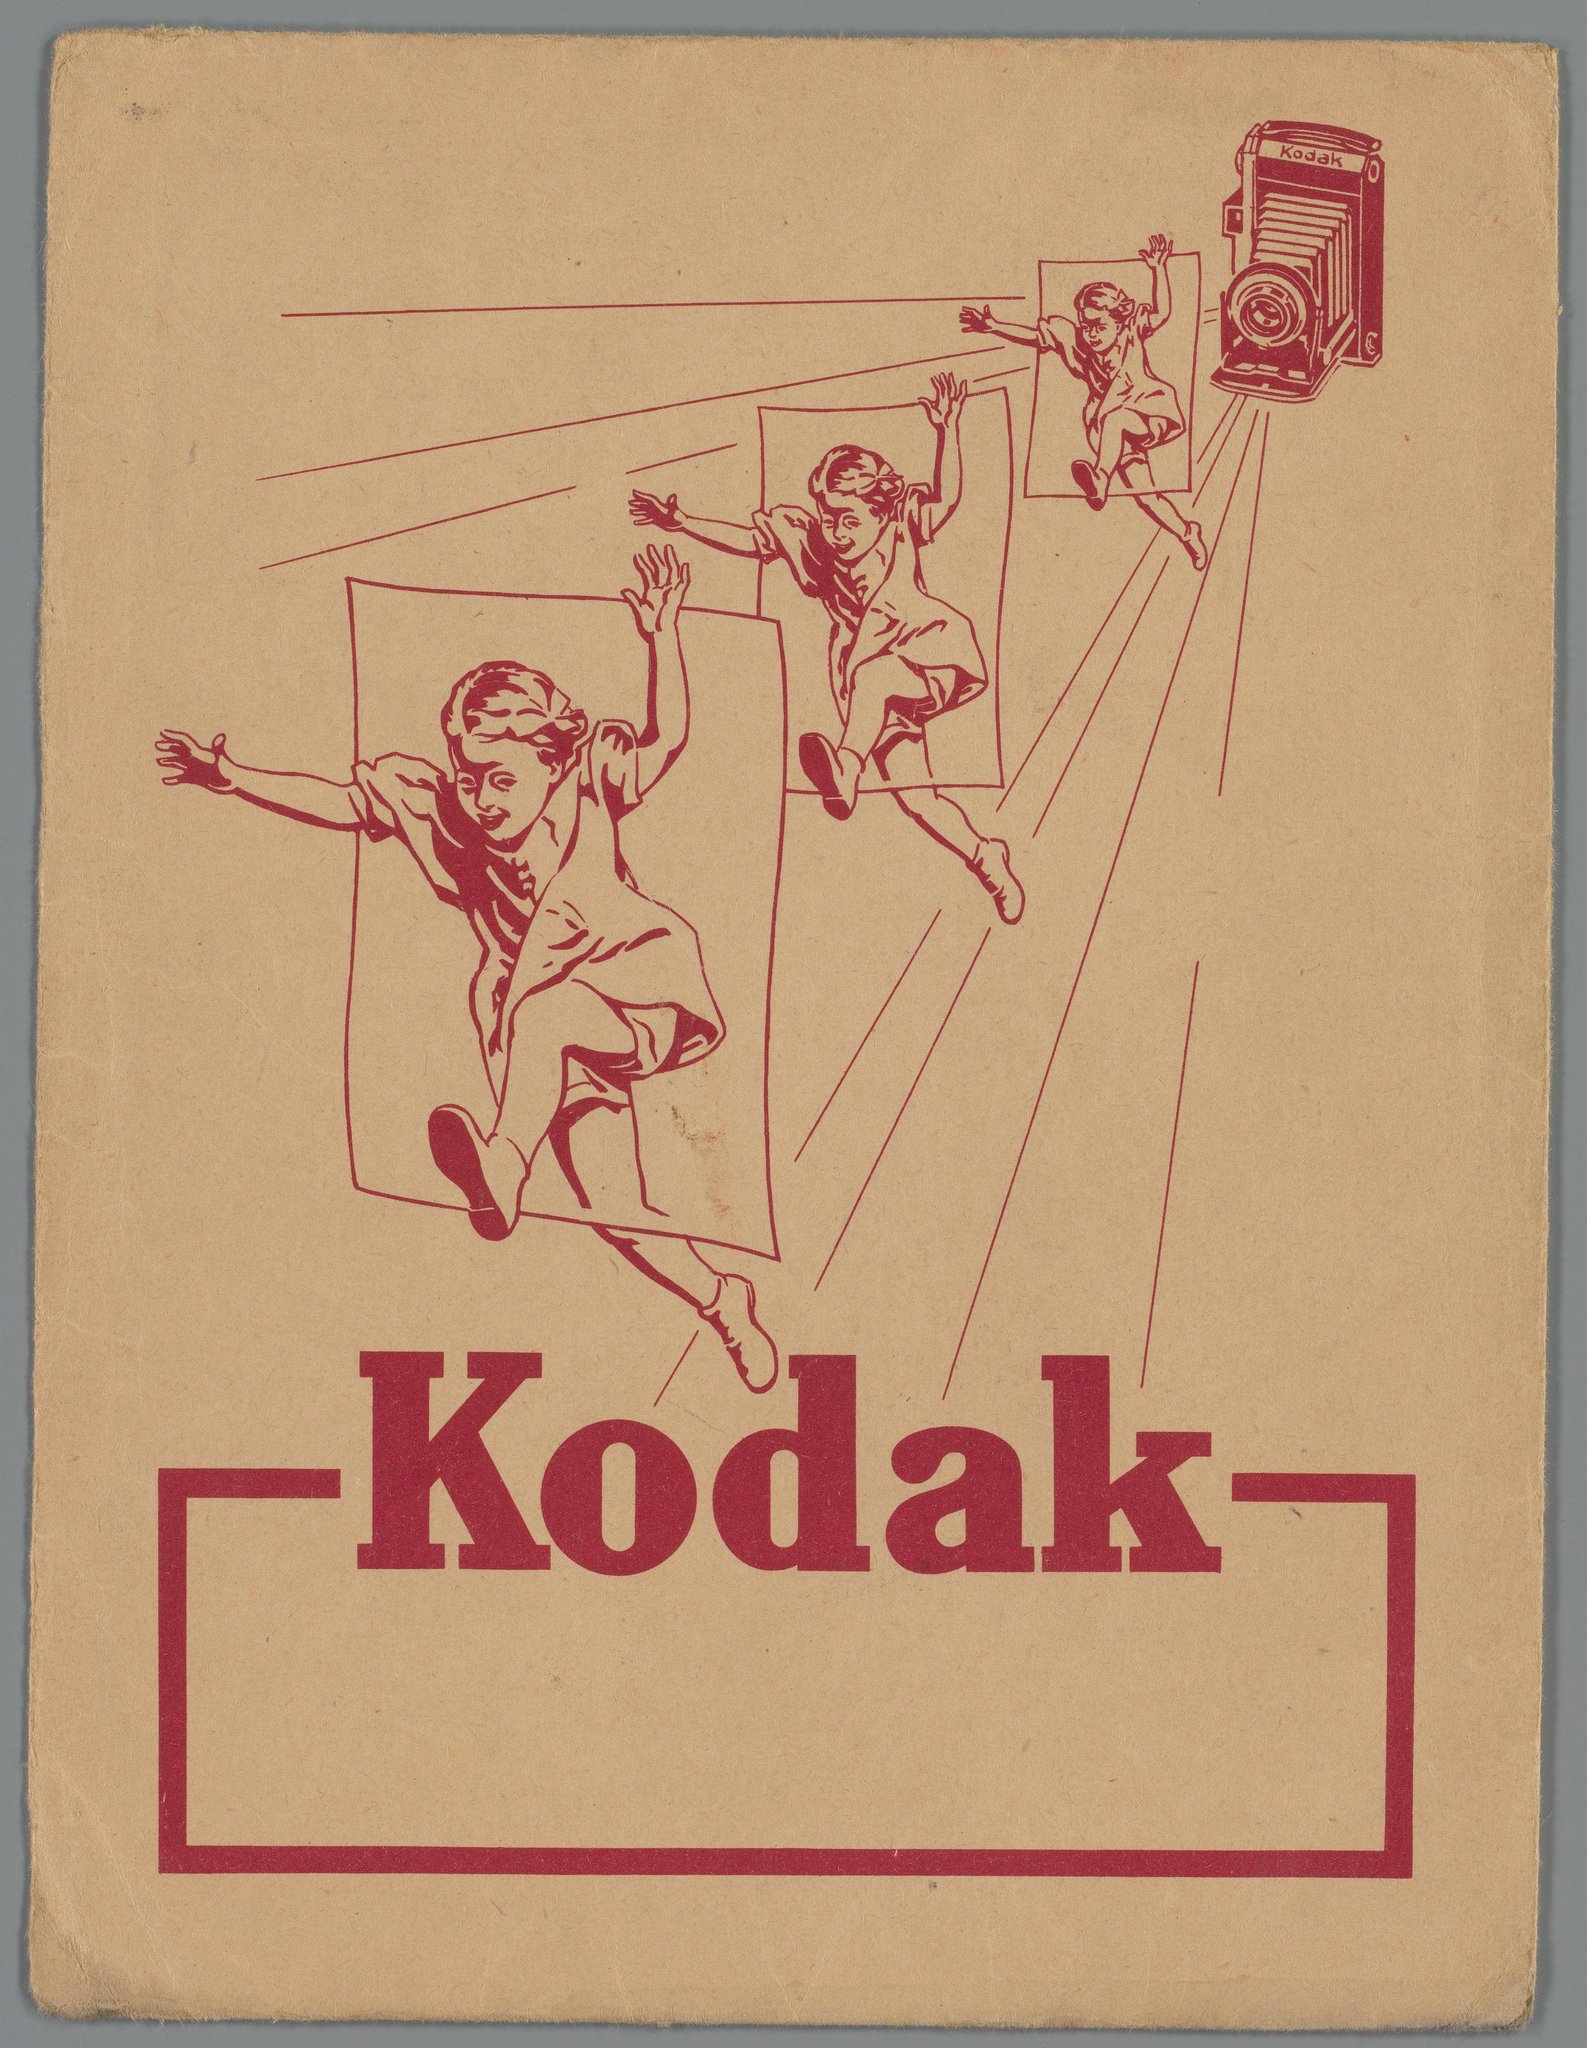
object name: envelope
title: Envelop voor Kodak vergrotingspapier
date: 1940-1960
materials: paper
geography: france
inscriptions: inscription: ‘9 x 12/ Agfa Brovira/ chamois/ 2x’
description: Envelop voor Agfa Brovira vergrotingspapieren in de kleur chamois.